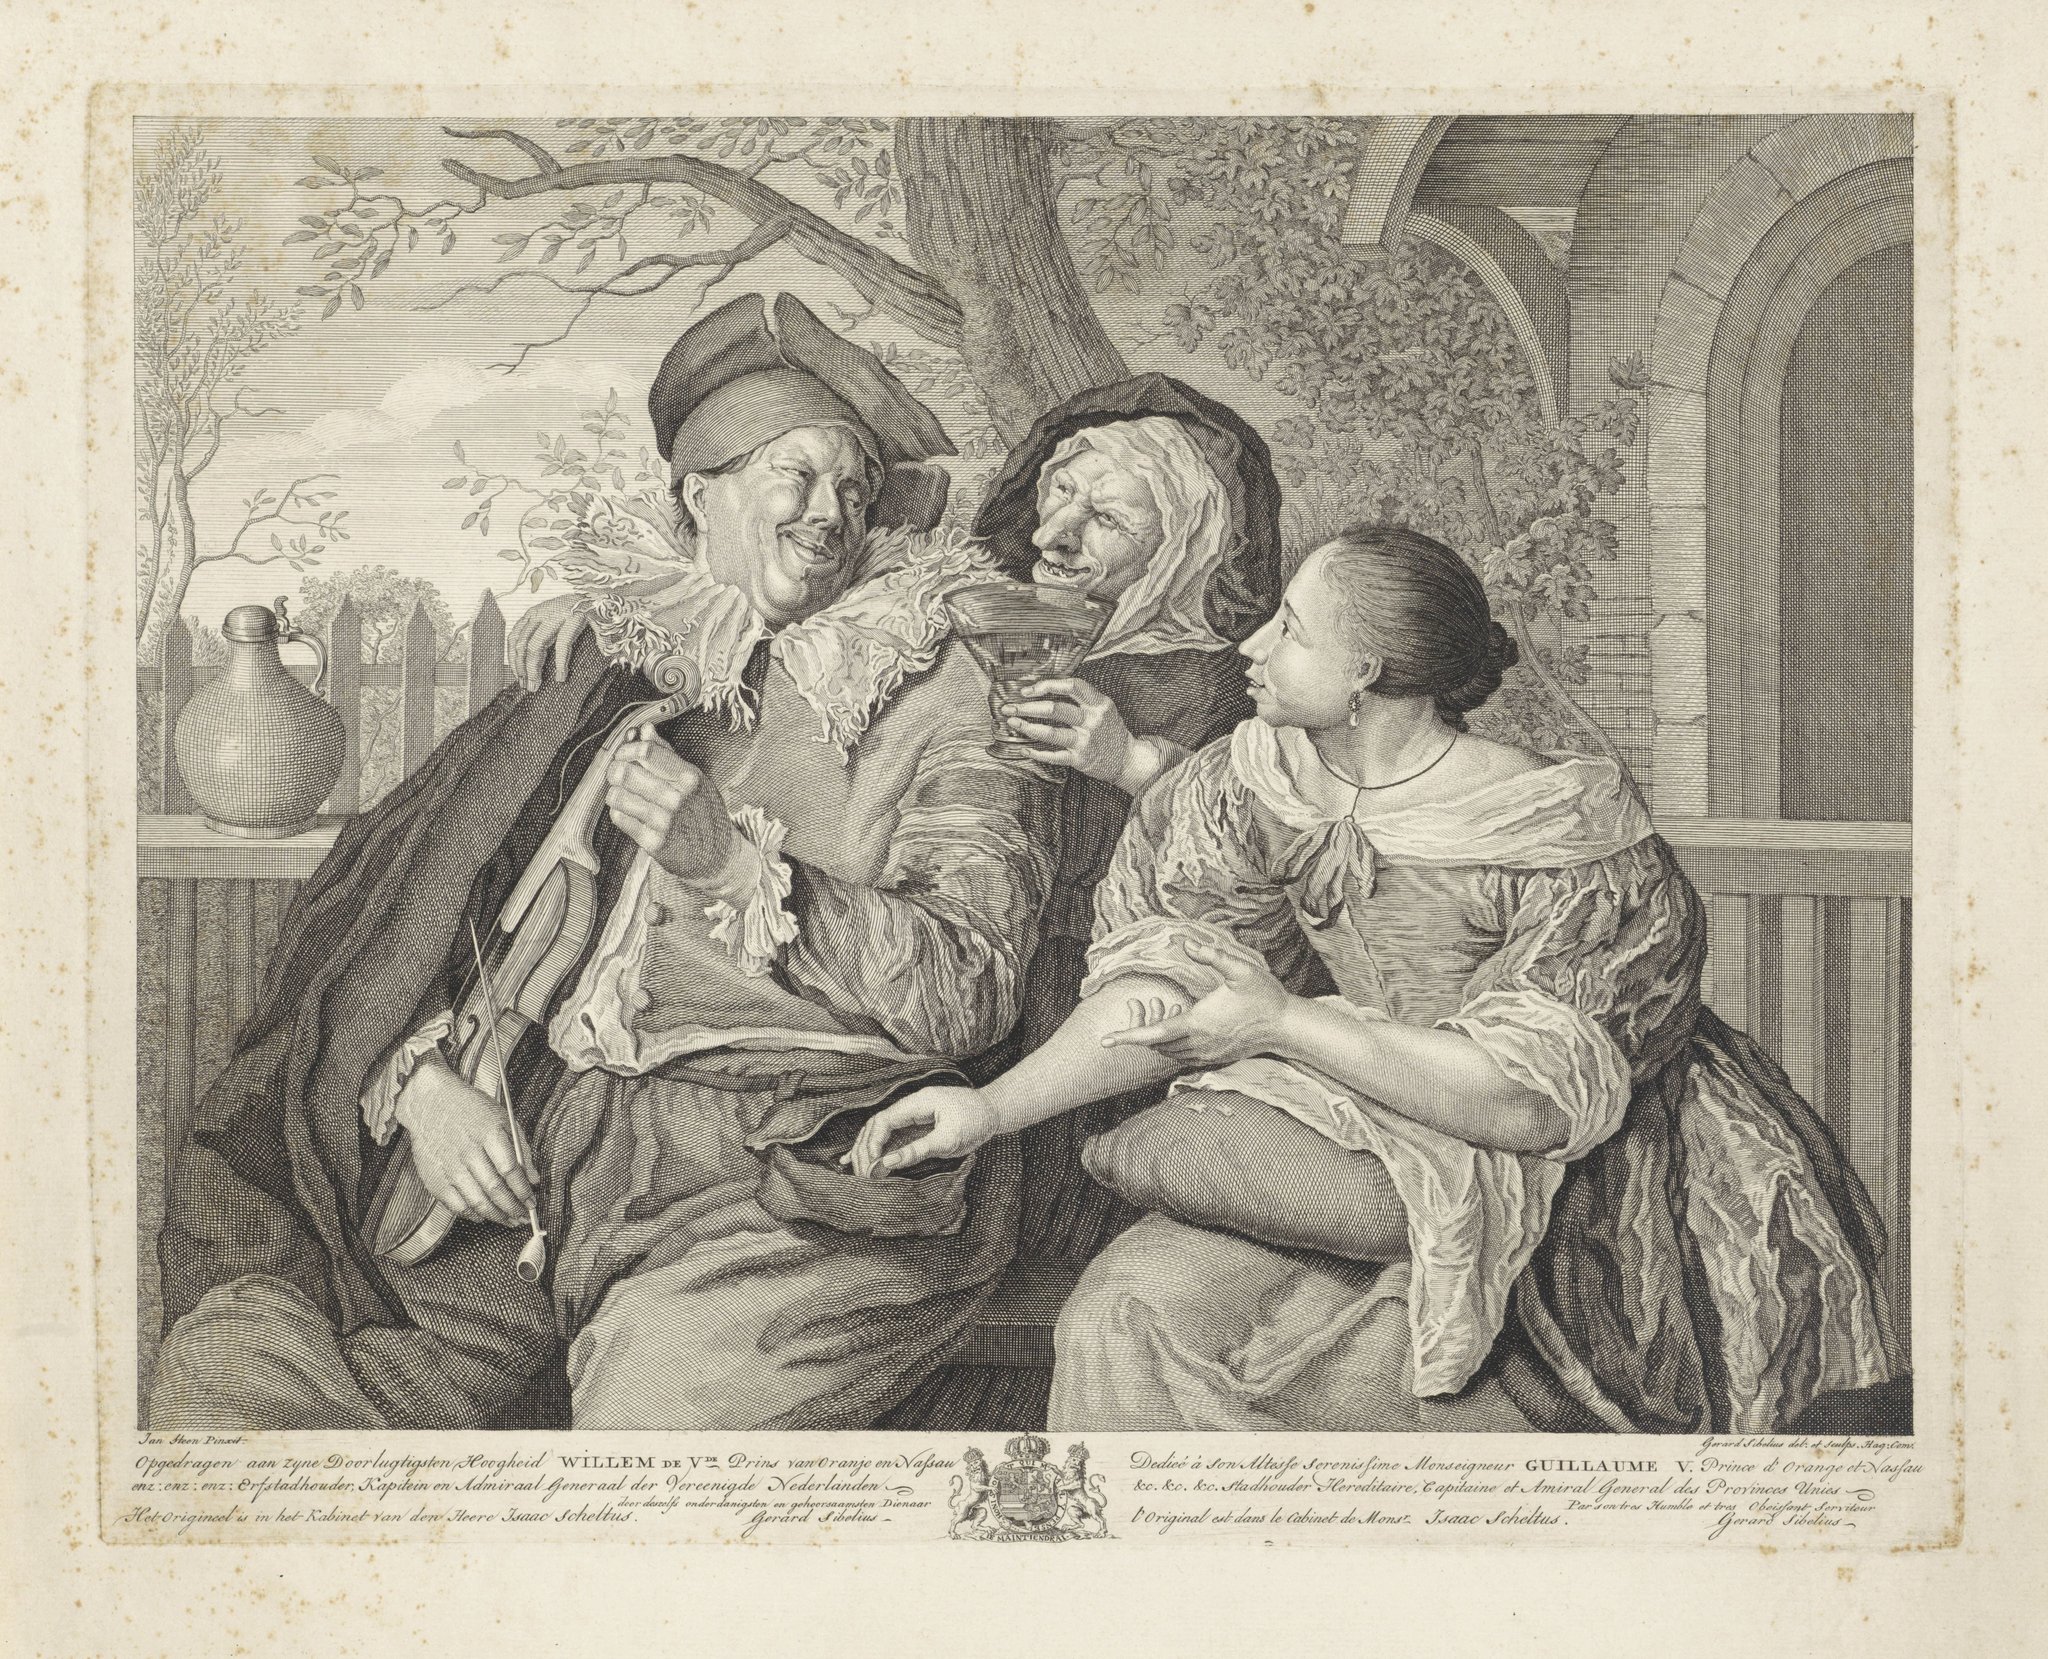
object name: print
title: Man met een viool in slecht gezelschap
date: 1755-1785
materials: paper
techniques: engraving, etching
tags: one person playing string instrument (bowed), pickpocket - gg - female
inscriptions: collector's mark: Lugt 240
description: Aan een tafel voor een herberg zit een vrolijke man met een viool. Terwijl een oude vrouw hem een glas aanreikt, steelt een jonge vrouw het geld uit zijn beurs. Onder de prent het wapenschild van stadhouder Willem V, aan weerszijden daarvan een opdracht in het Nederlands en Frans.